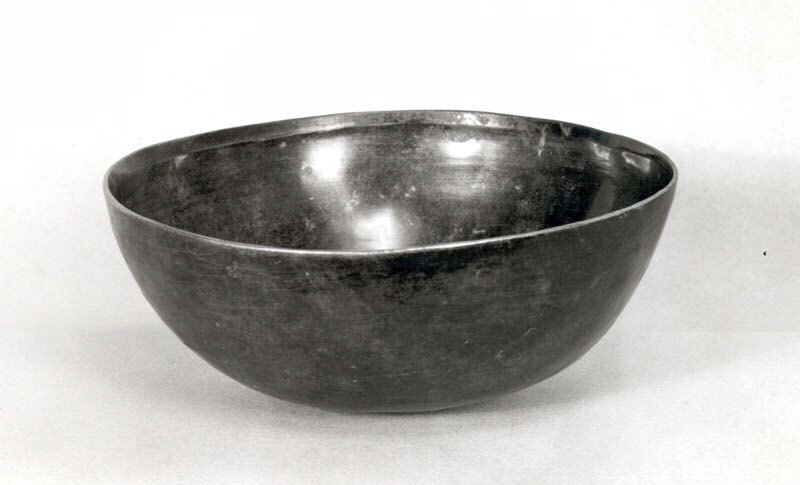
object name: vessel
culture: sasanian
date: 201-700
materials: bronze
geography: iran